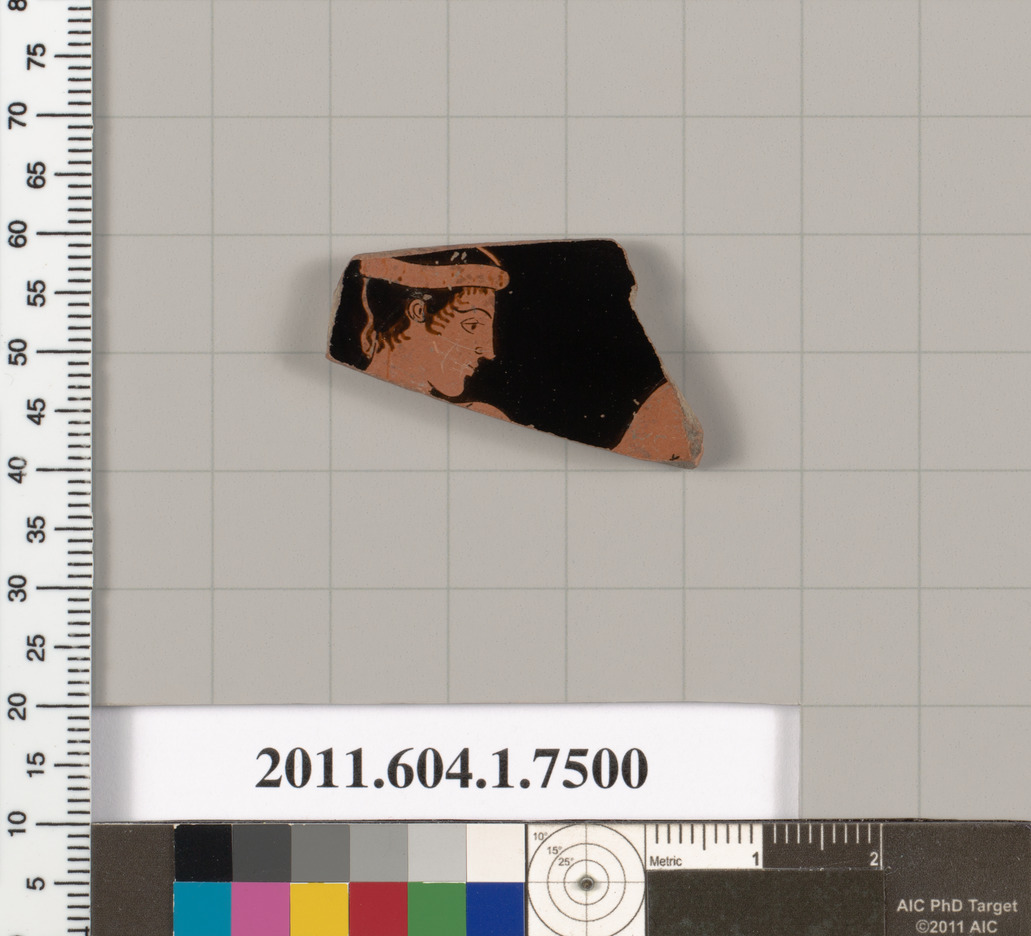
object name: kylix fragment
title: Terracotta fragment of a kylix (drinking cup)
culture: greek, attic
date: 460-450 BCE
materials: terracotta